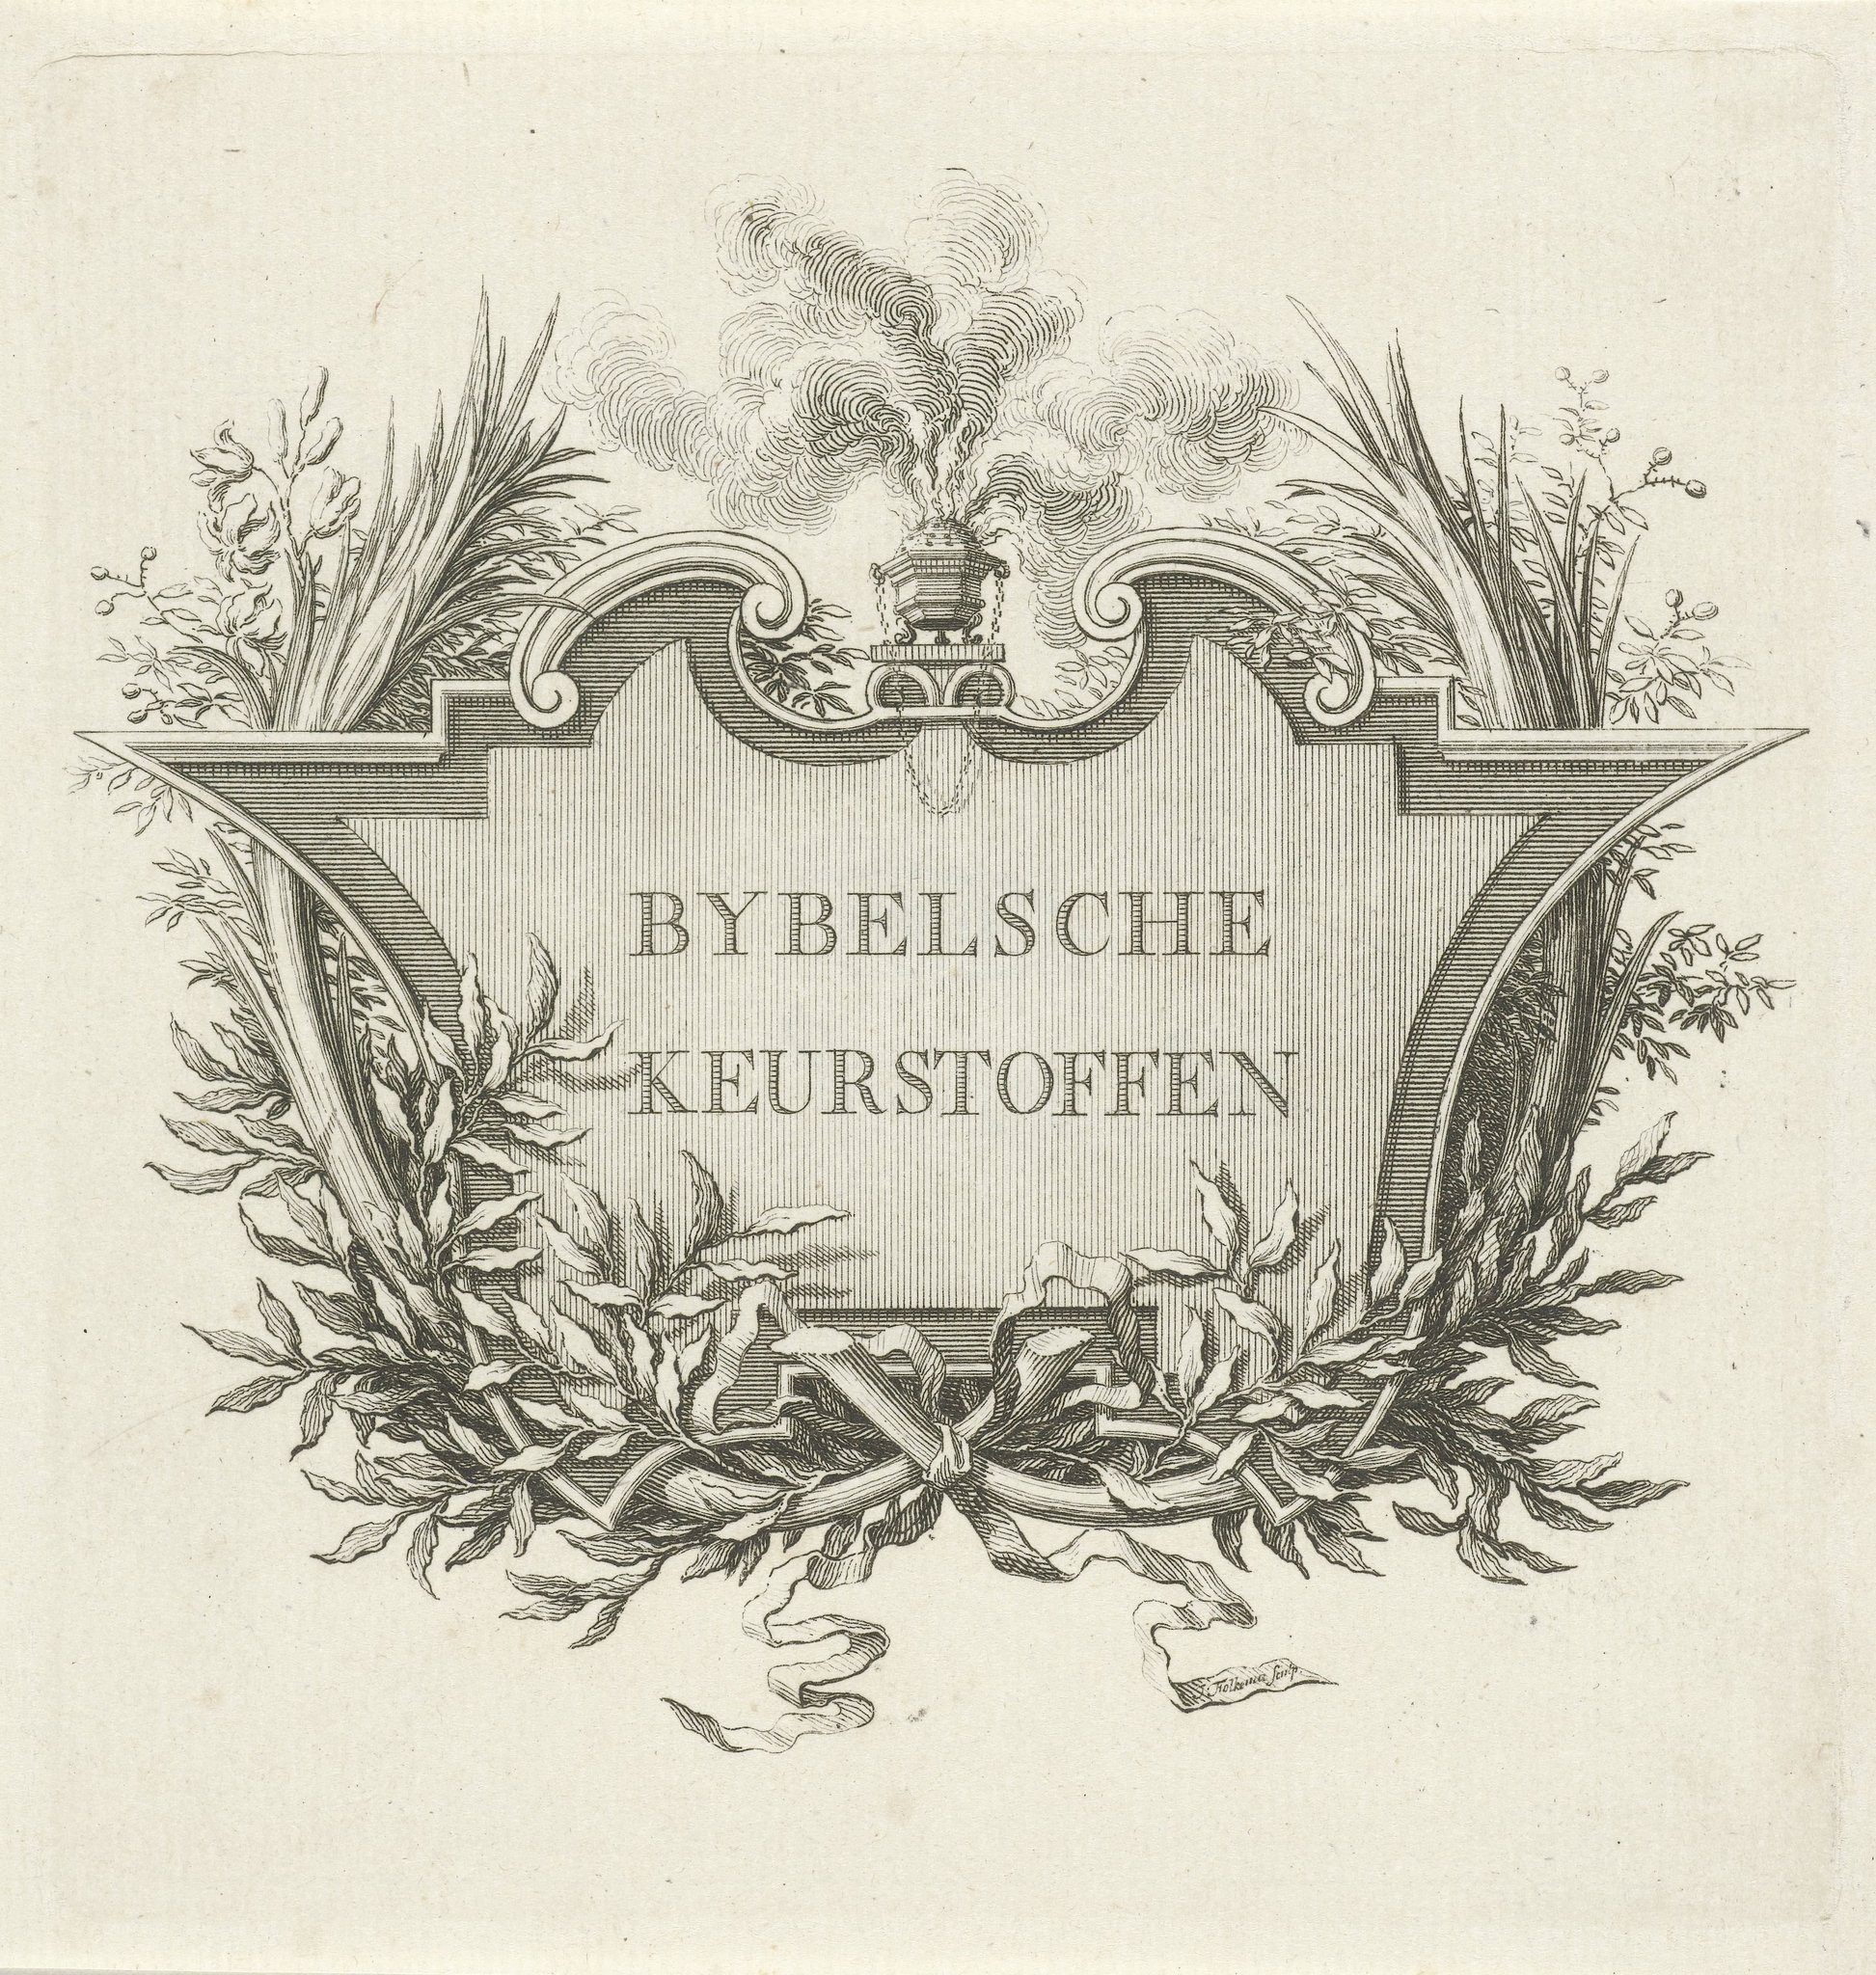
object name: print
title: Plaquette getooid met wierookvat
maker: jacob folkema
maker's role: draughtsman, print maker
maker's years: 1692-1767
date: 1702-1767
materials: paper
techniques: etching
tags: incense-burner ~ scents, perfumes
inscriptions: collector's mark: Lugt 2228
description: Plaquette met titel, omgeven door palm- en olijftakken, en getooid met een wierookvat.